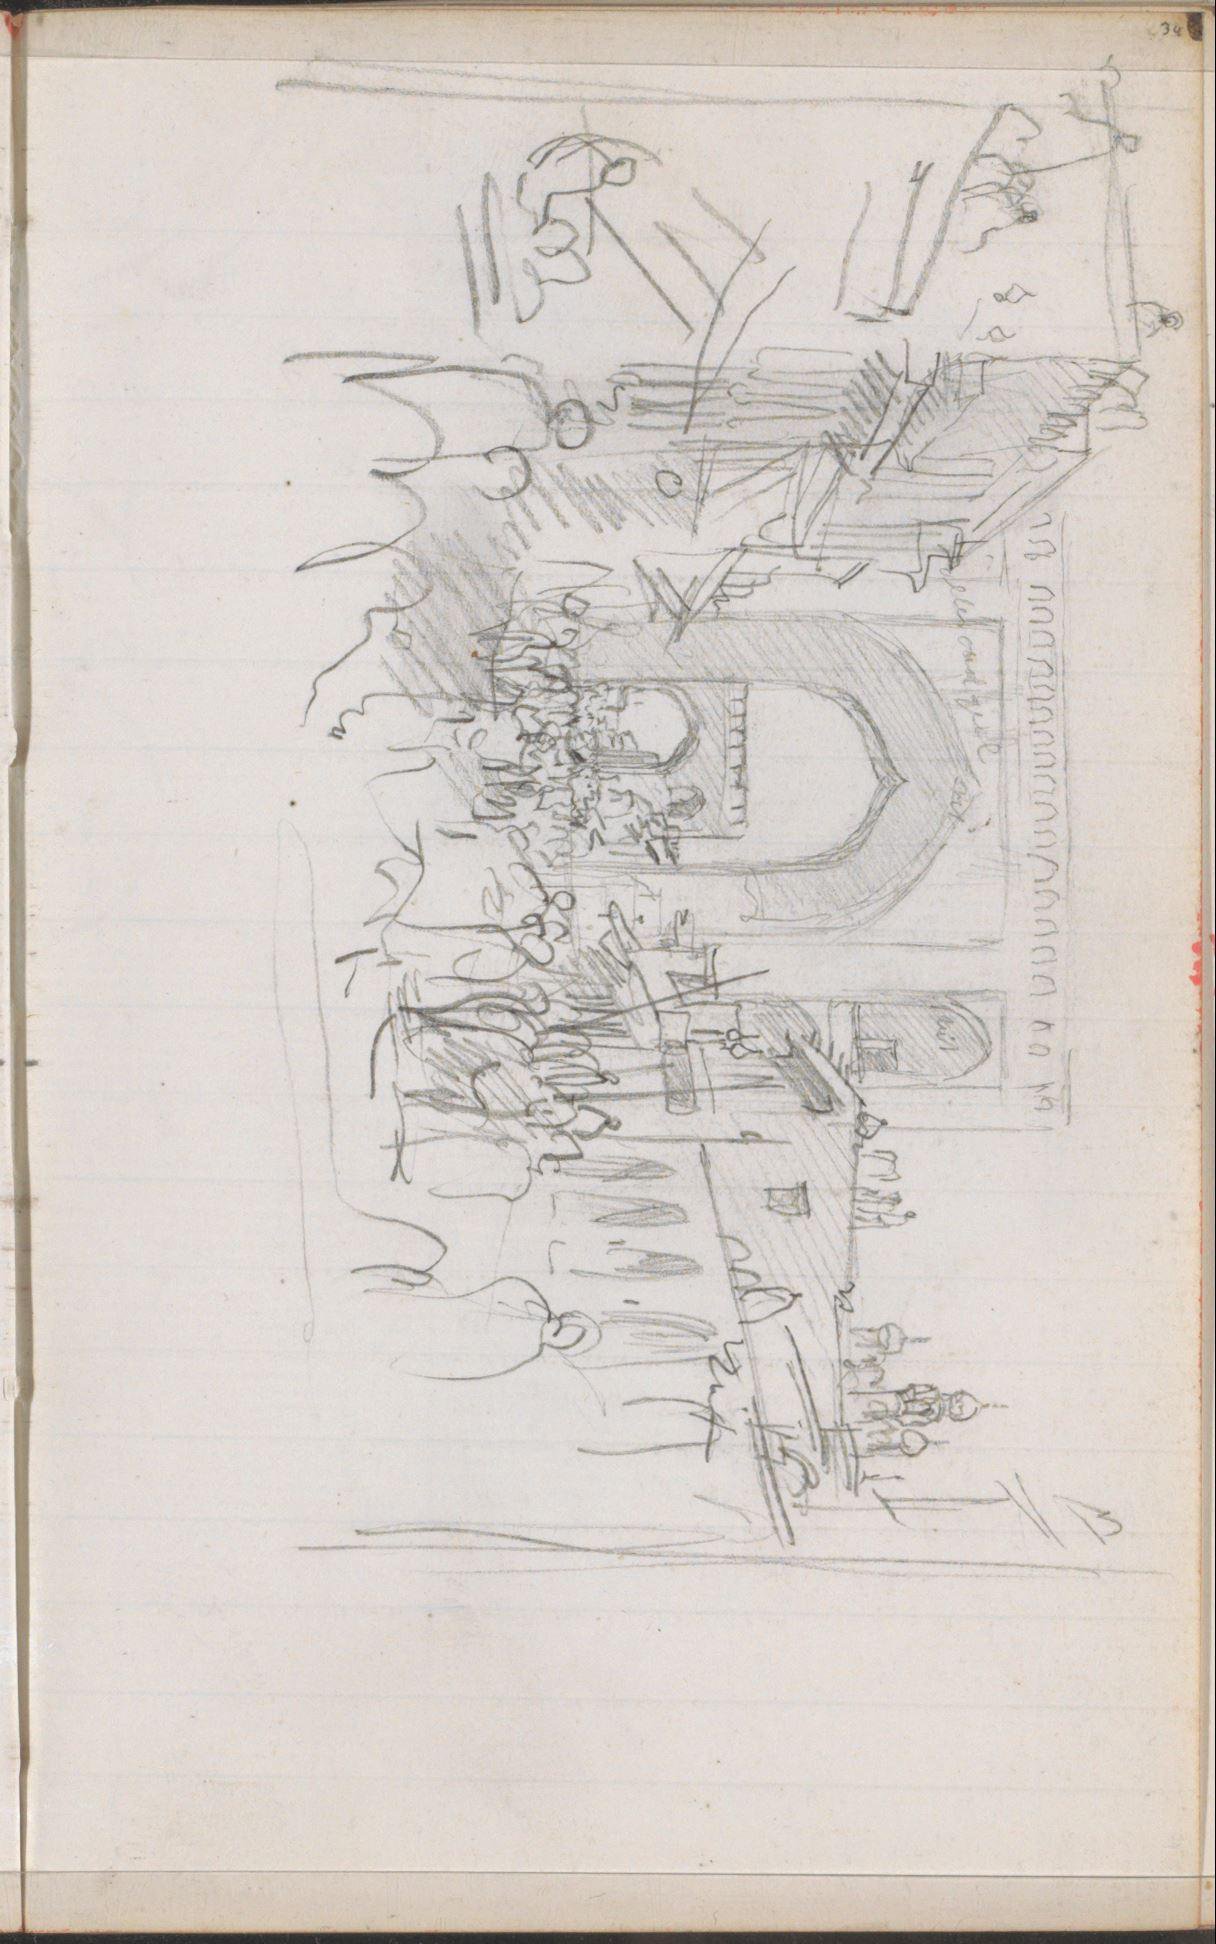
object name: sketchbook leaf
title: Straat met poorten, vermoedelijk in Hyderabad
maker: marius bauer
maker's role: draughtsman, print maker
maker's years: 1867-1932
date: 1897-1898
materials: pencil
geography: hyderabad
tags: arch, archivolt ~ architecture, street (+ city(-scape) with figures, staffage)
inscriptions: kleurnotitie, handgeschreven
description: Op de straat lopen figuren en er zitten figuren op de daken. In de verte de koepels, vermoedelijk van een tempel. Pagina 34 uit een schetsboek met 62 bladen.